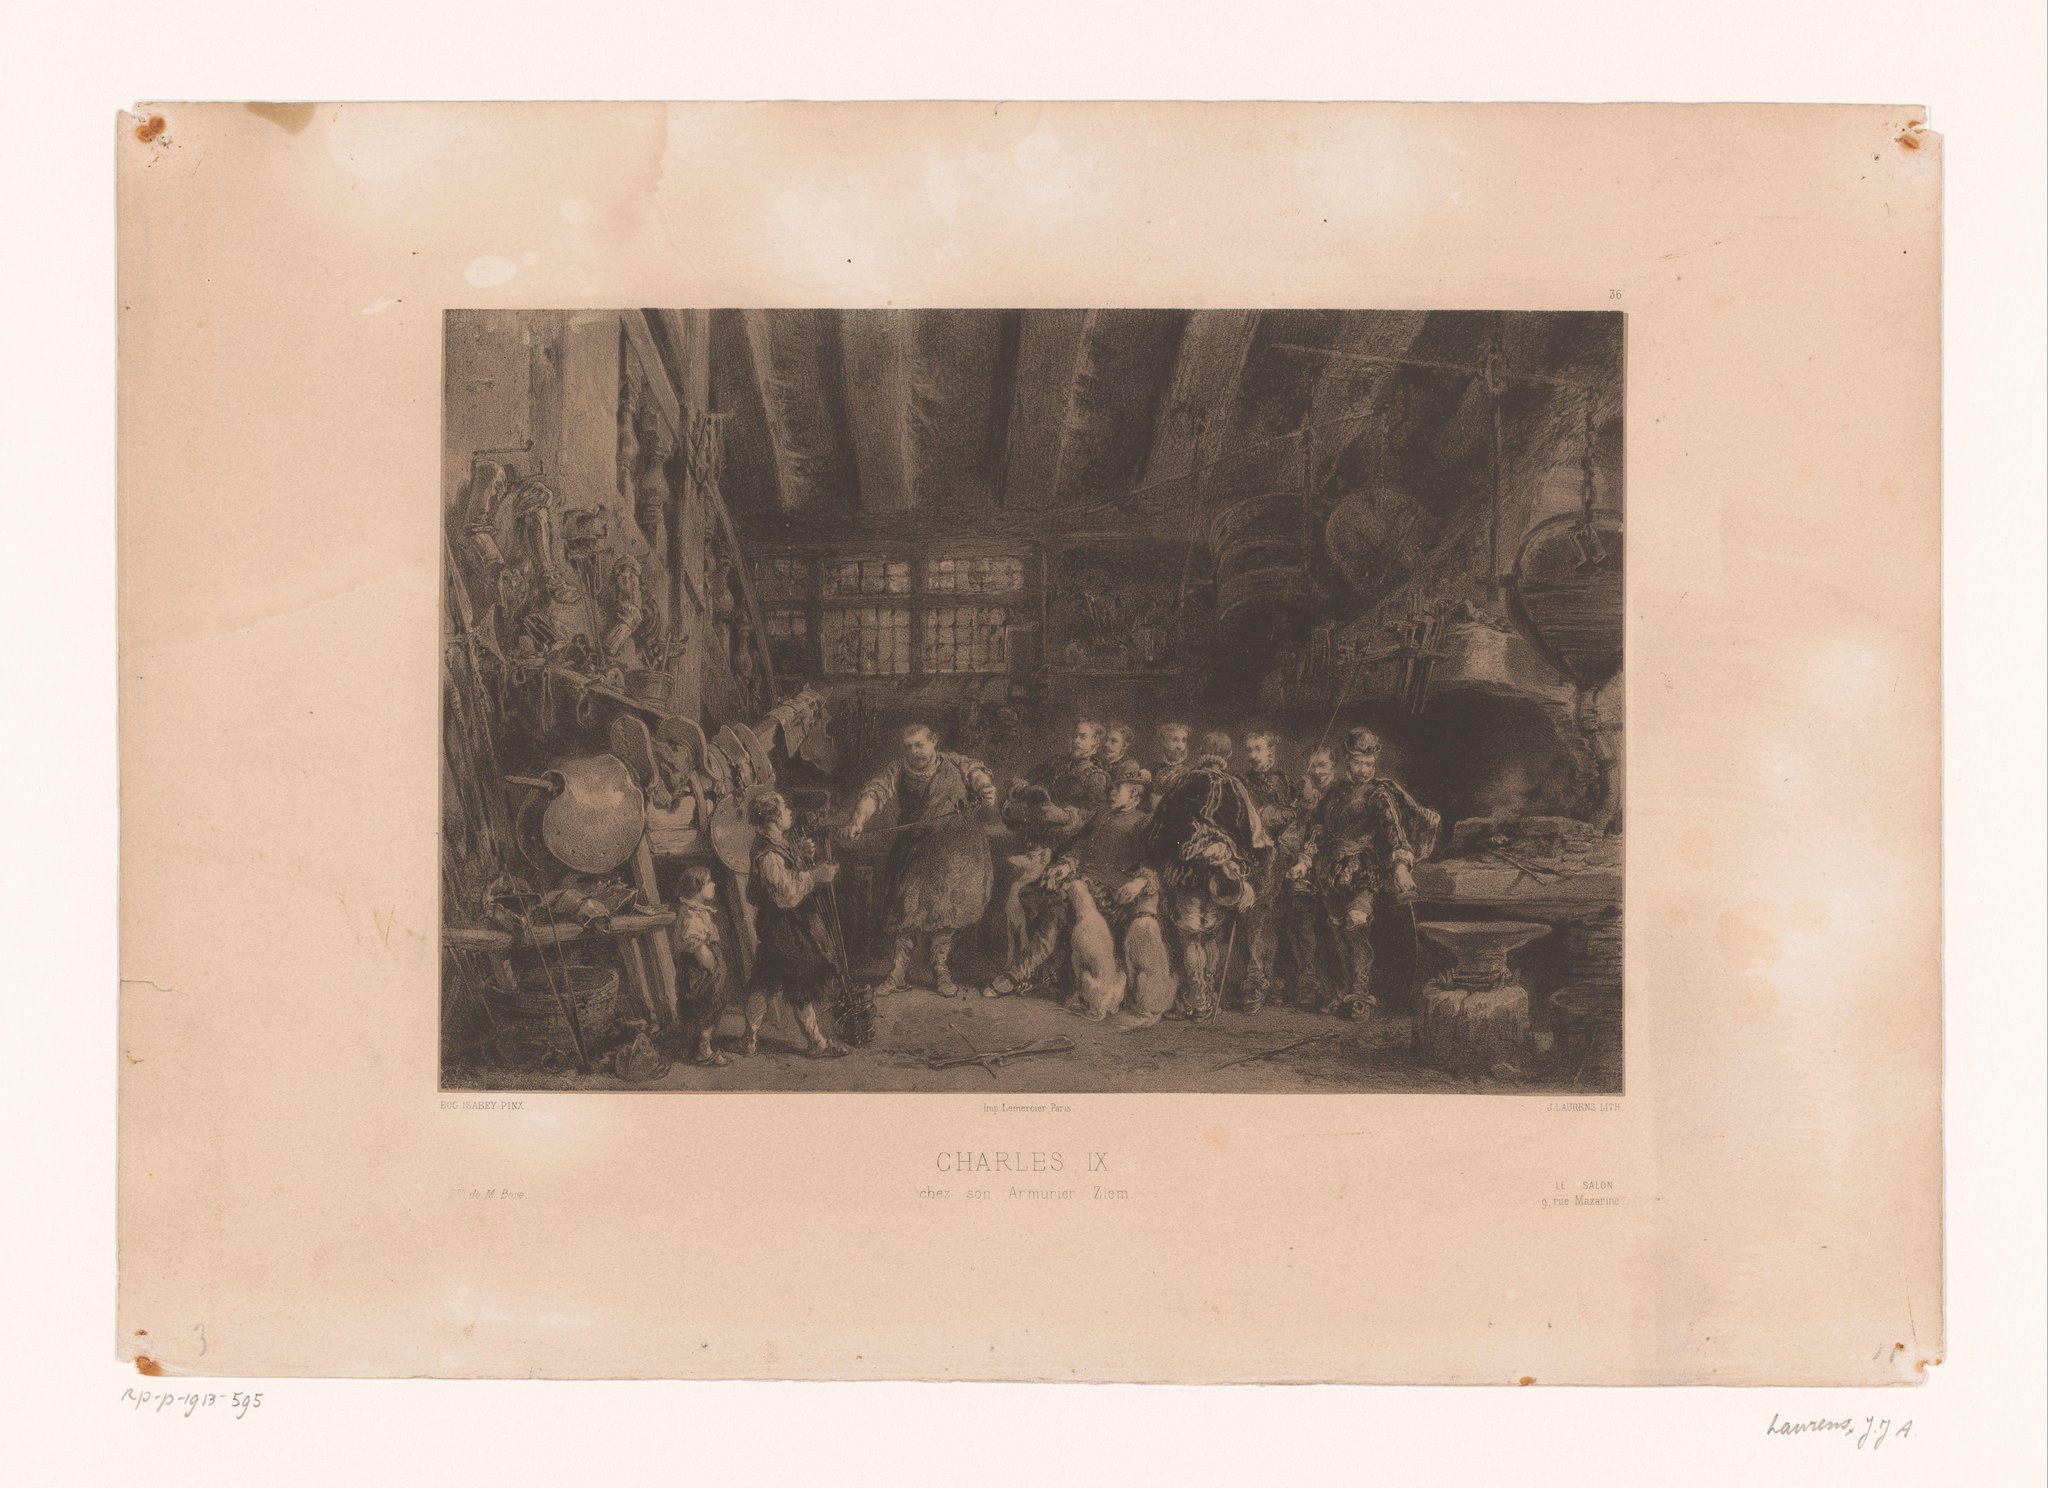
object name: print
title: Karel IX in de smidse van zijn wapensmid Ziem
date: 1855-1860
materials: paper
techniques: lithograph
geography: paris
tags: karel ix (koning van frankrijk), historical persons, king, forging (industrial process), gun-smith, rifle-maker, armourer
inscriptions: collector's mark: Lugt 2233, check stamp: Lugt 5313